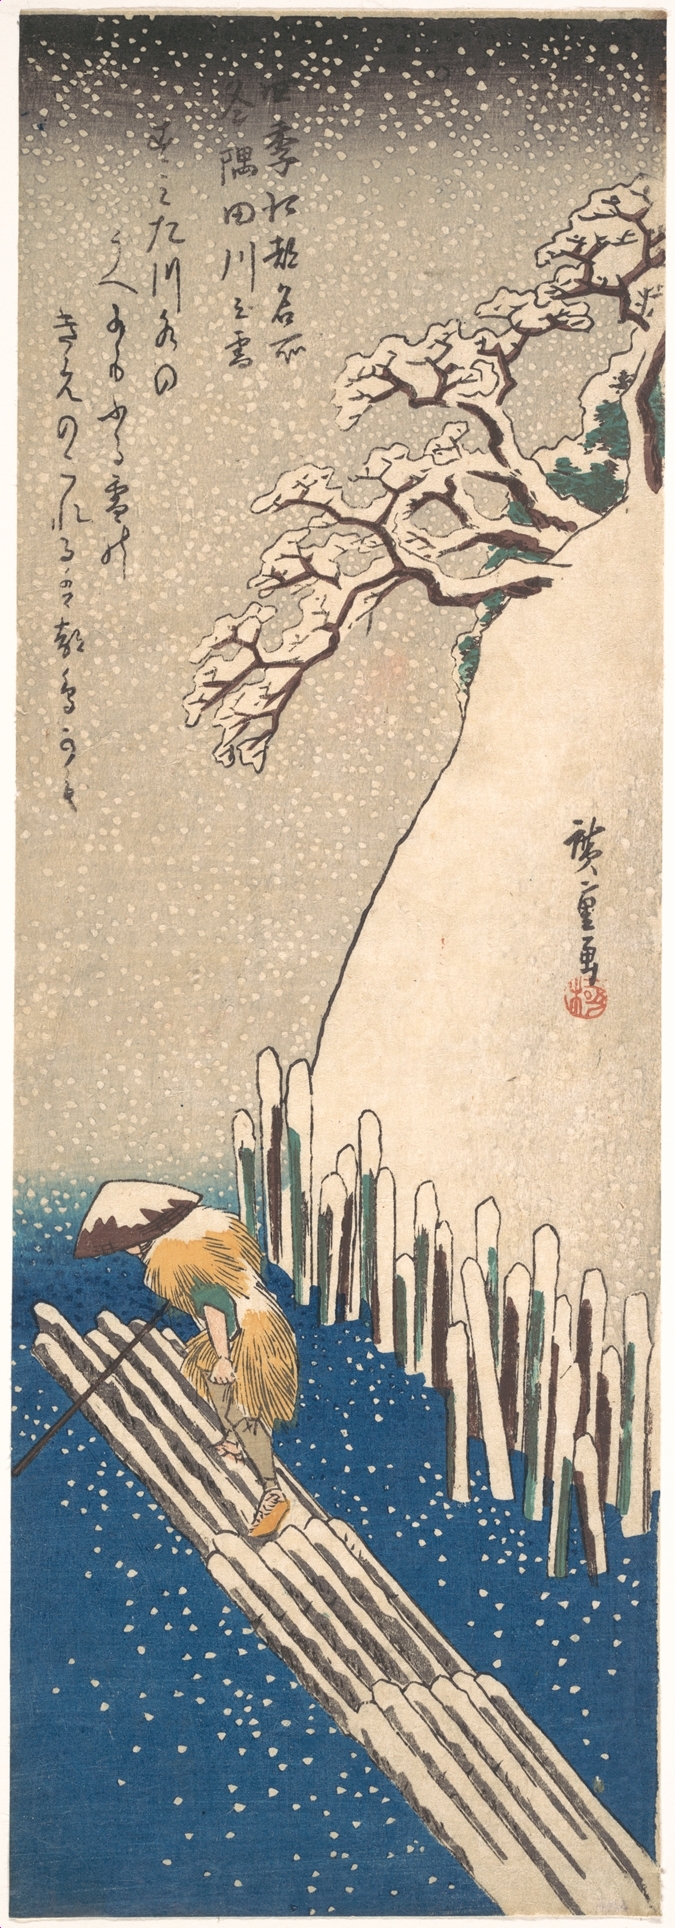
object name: print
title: Snow on the Sumida River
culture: japanese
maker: utagawa hiroshige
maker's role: artist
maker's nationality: japanese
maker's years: 1797-1858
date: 1835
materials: ink, paper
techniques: woodblock print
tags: human figures,rivers,trees,snow